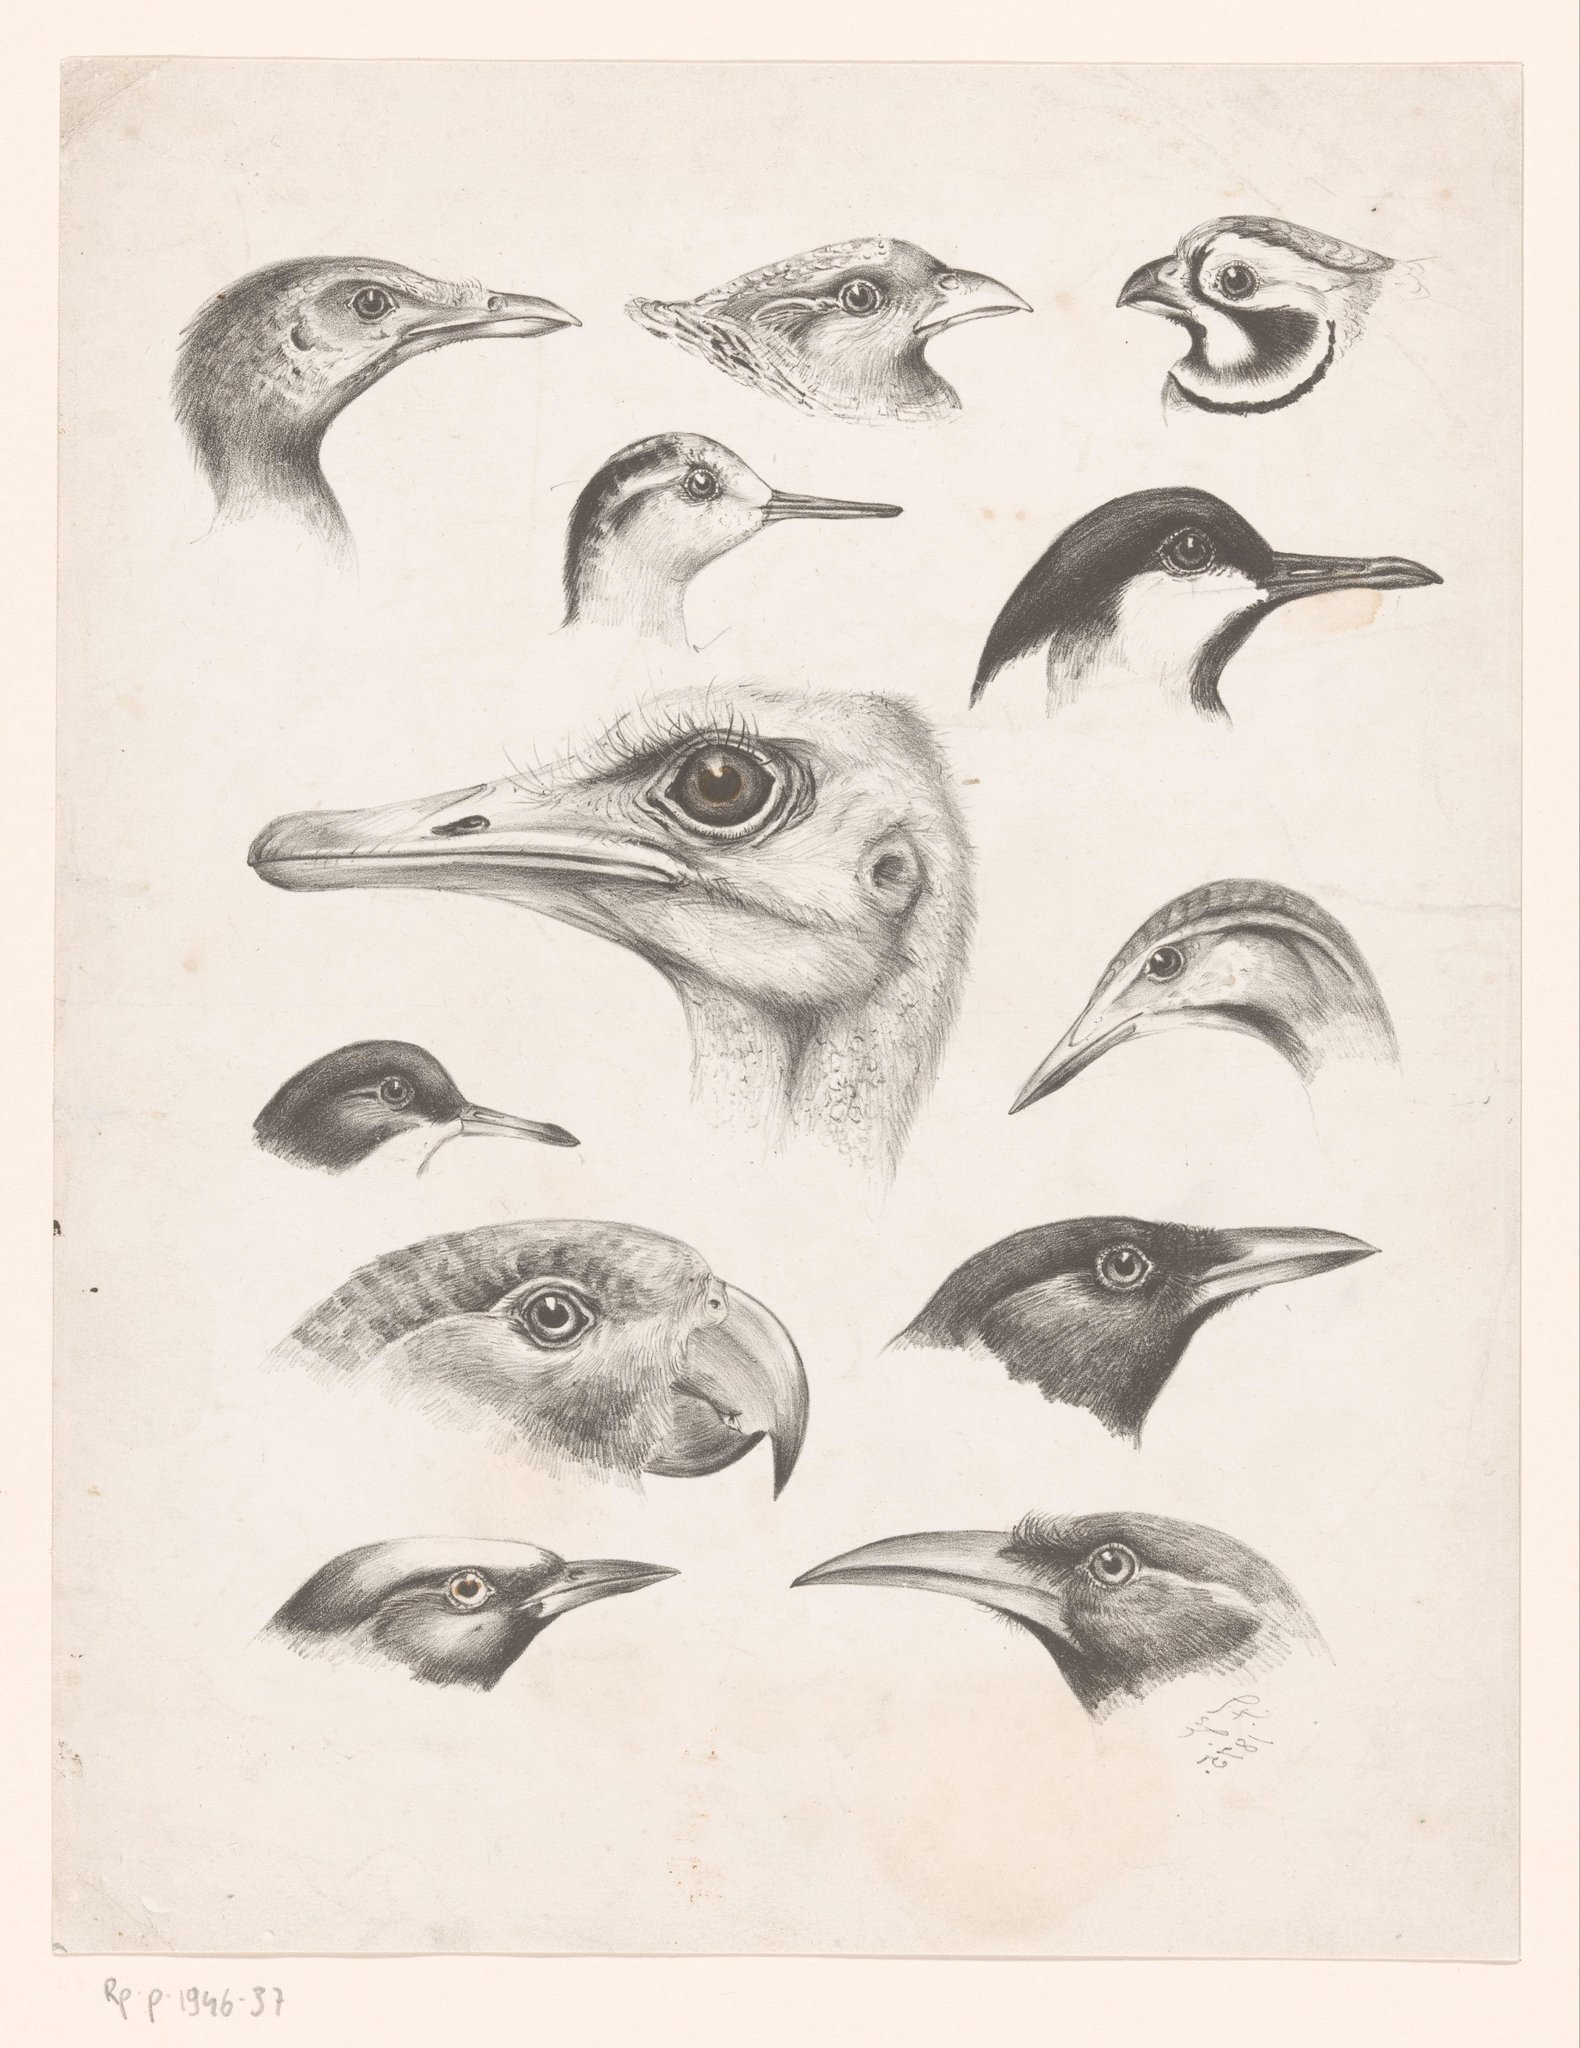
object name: print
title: Twaalf vogelkoppen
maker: floris verster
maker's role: draughtsman, painter, print maker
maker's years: 1861-1927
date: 1875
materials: paper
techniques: lithograph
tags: birds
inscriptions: collector's mark: Lugt 2760, collector's mark: Lugt 2228